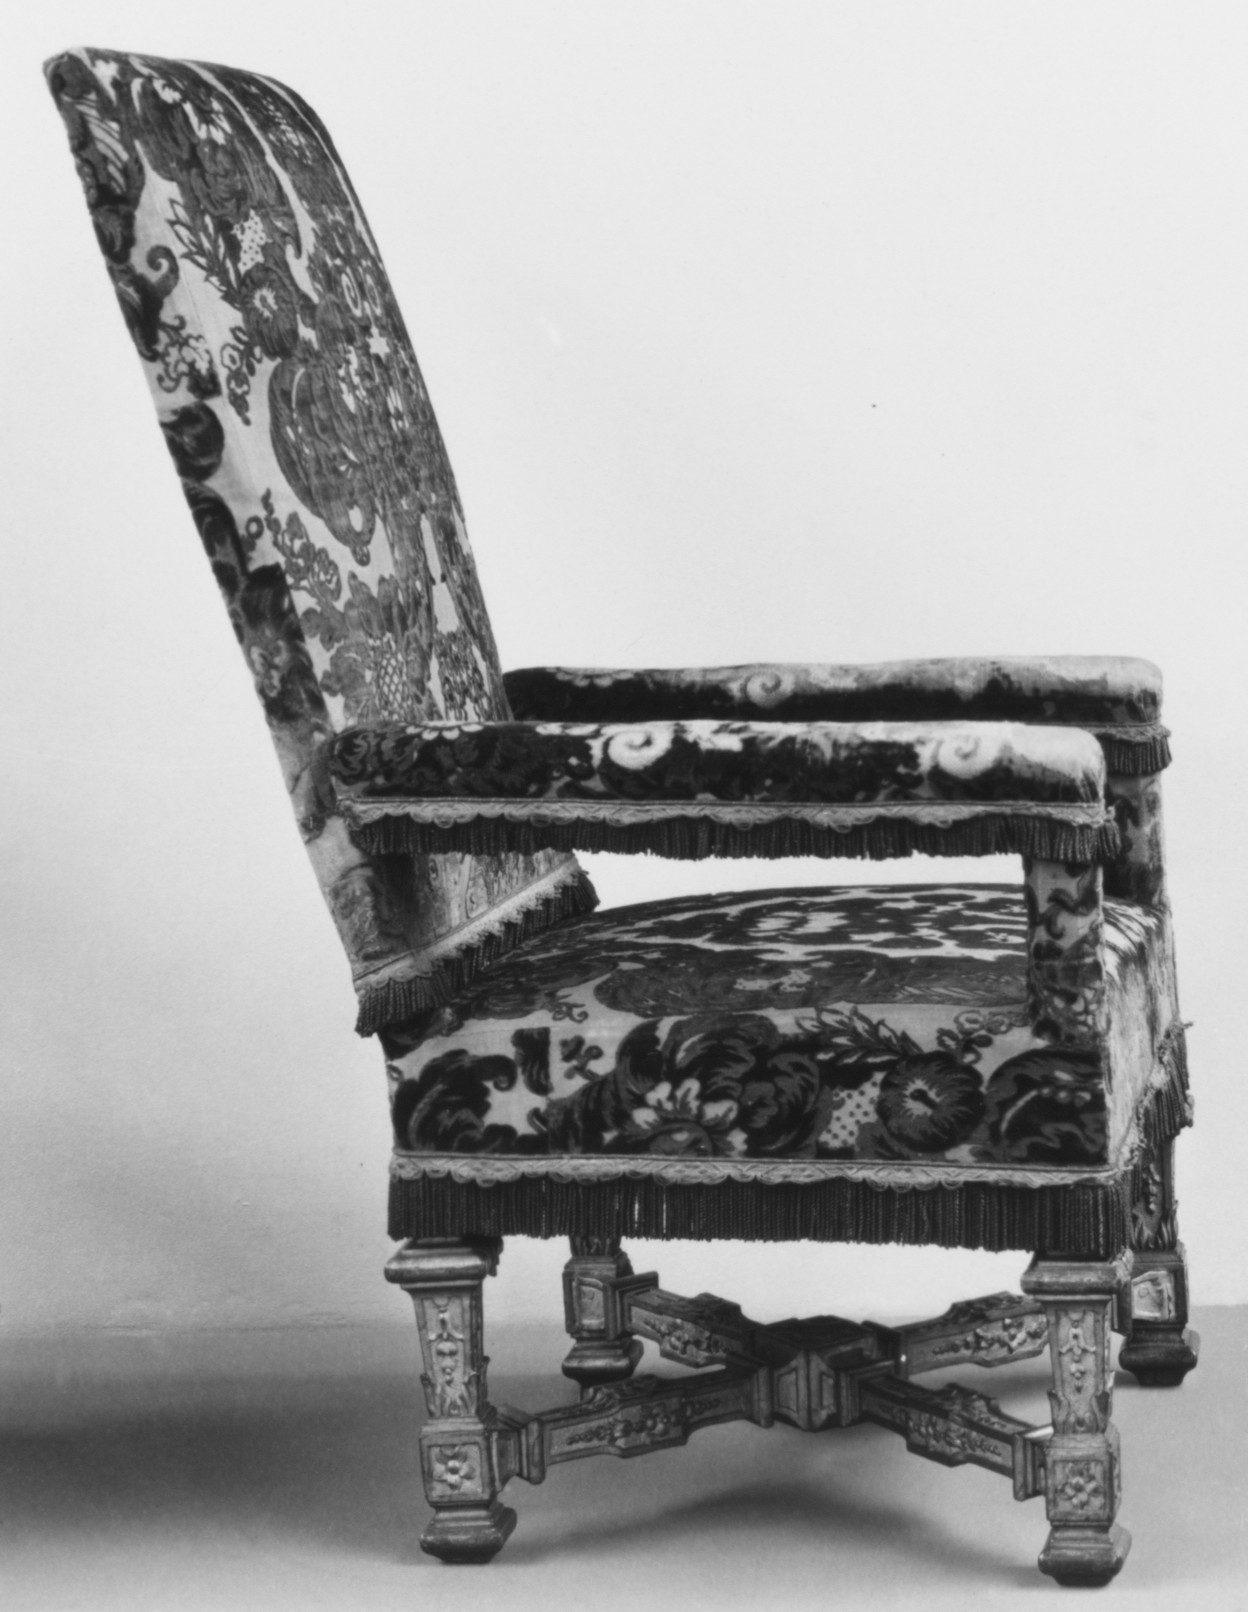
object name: armchair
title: Armchair (one of a pair)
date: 1676-1700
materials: wood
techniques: carving, gilding